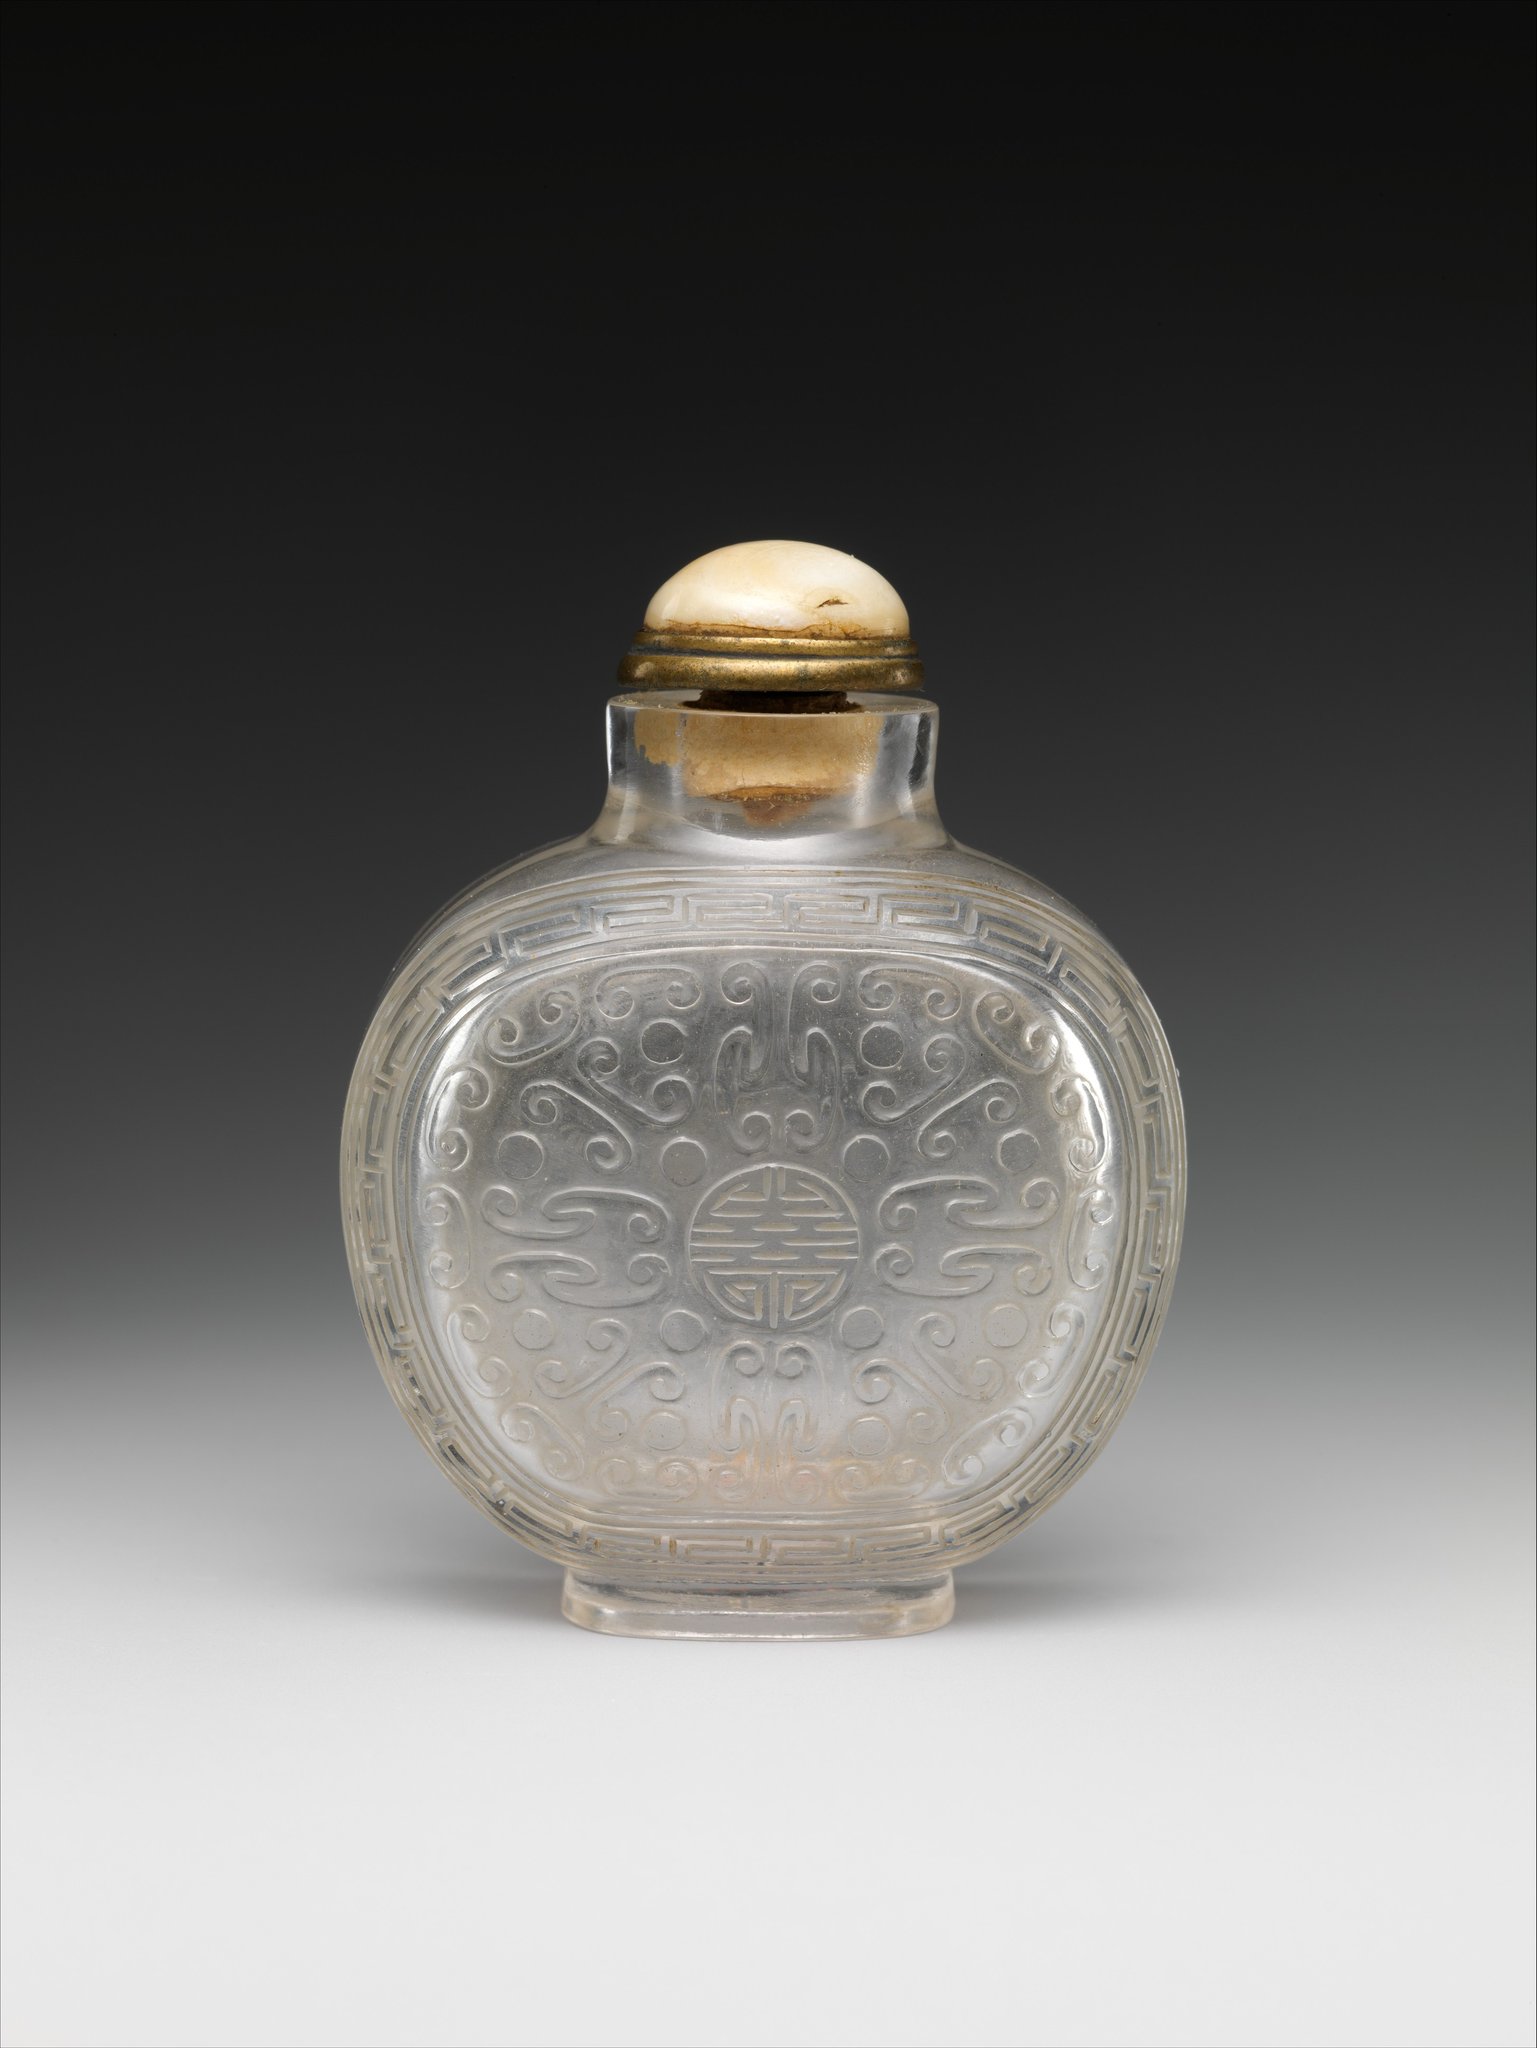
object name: snuff bottle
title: Snuff bottle with the character of longevity (shou)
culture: chinese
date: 1801-1900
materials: quartz